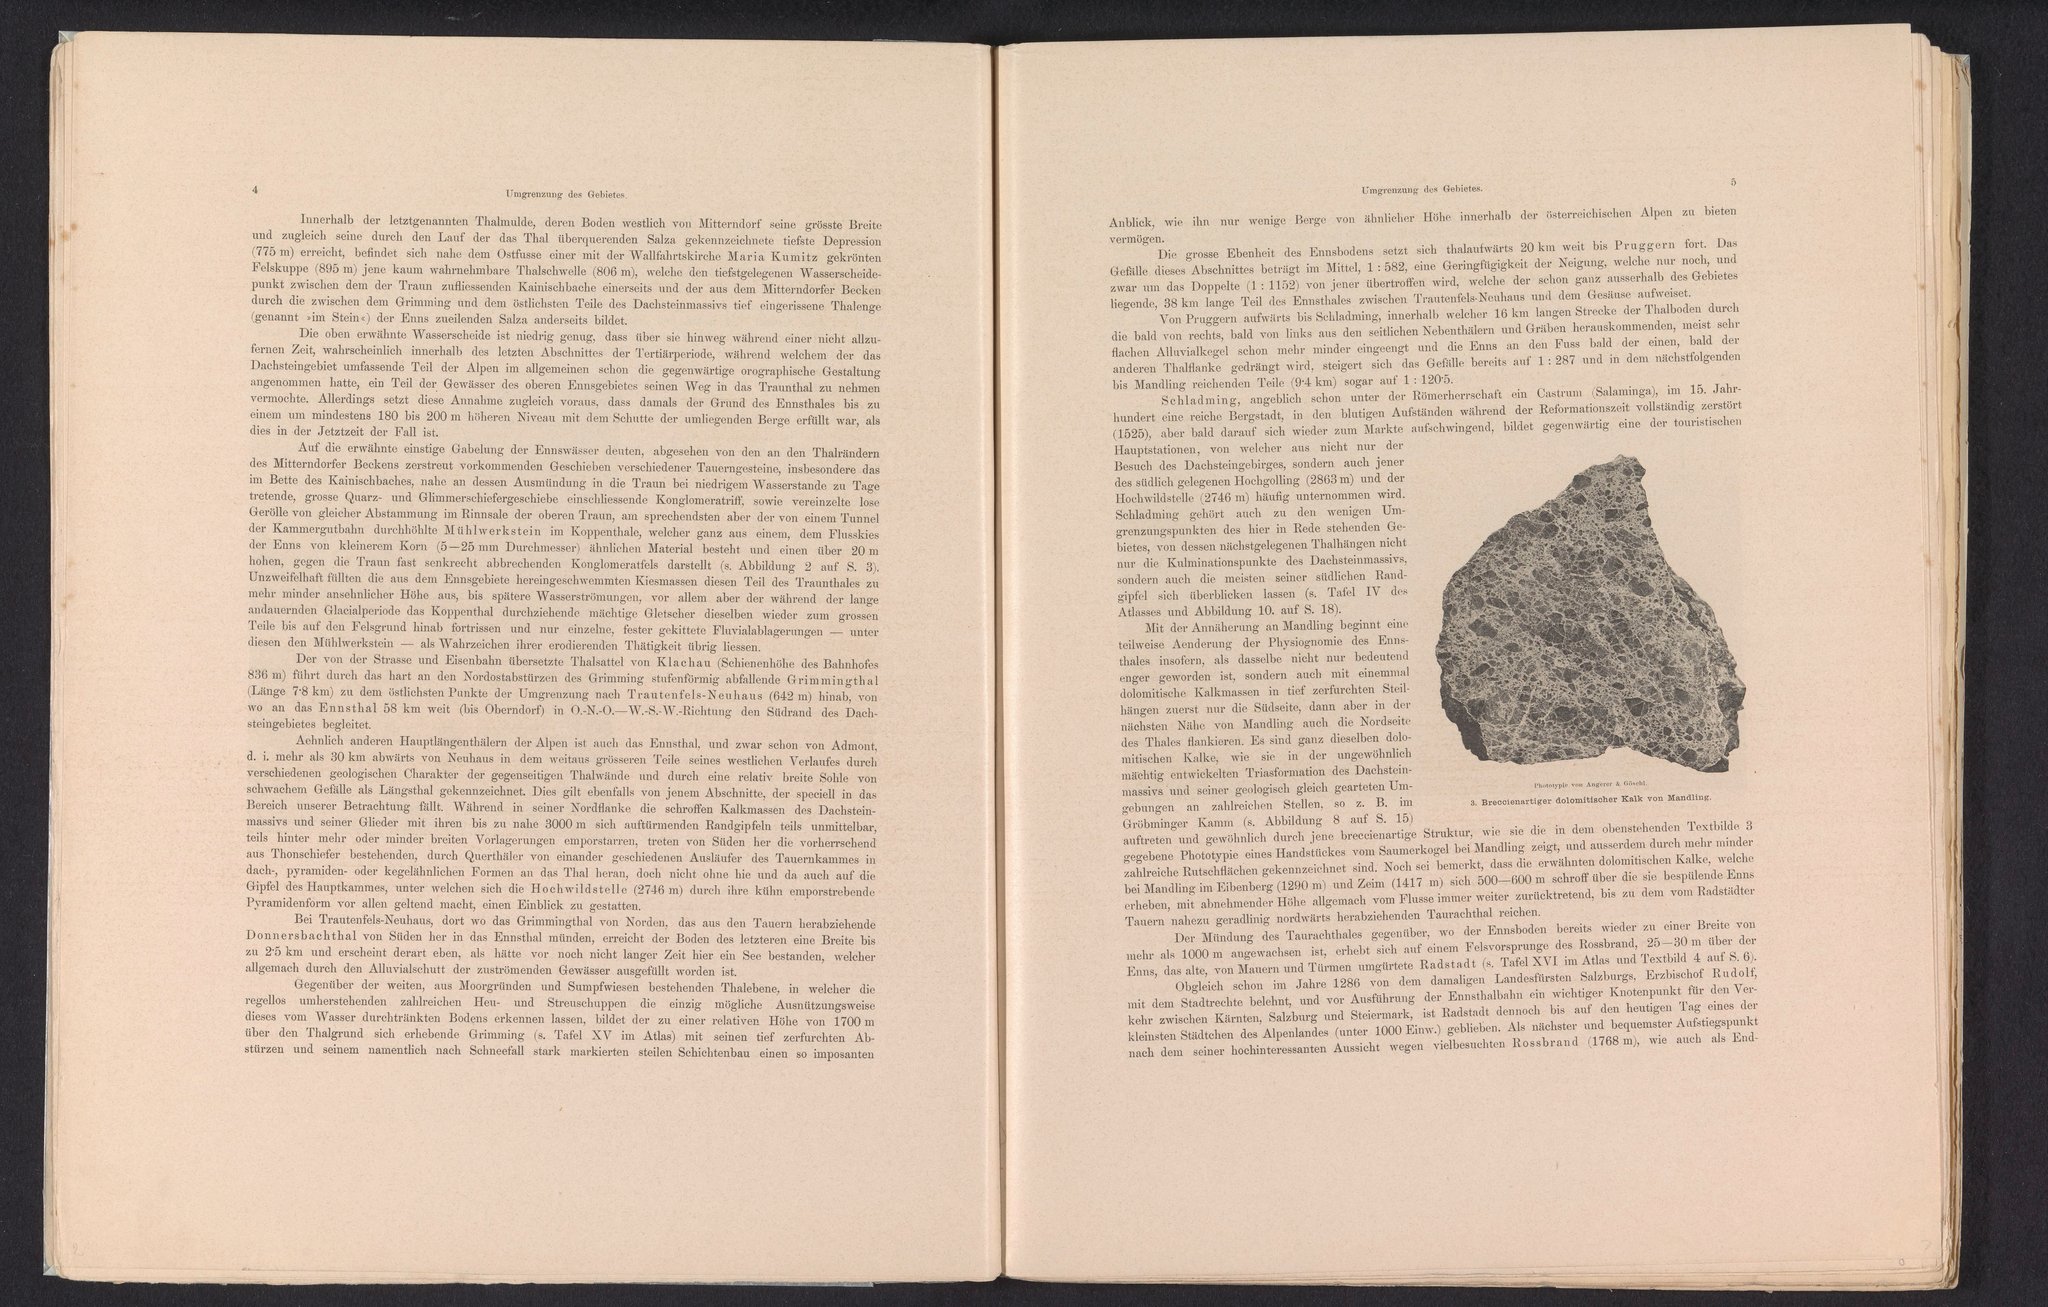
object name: photomechanical print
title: Kalksteen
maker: friedrich simony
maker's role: geograaf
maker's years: 1813-1896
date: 1879-1889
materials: paper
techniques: autotype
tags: boulder, stone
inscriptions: number: ‘3.’